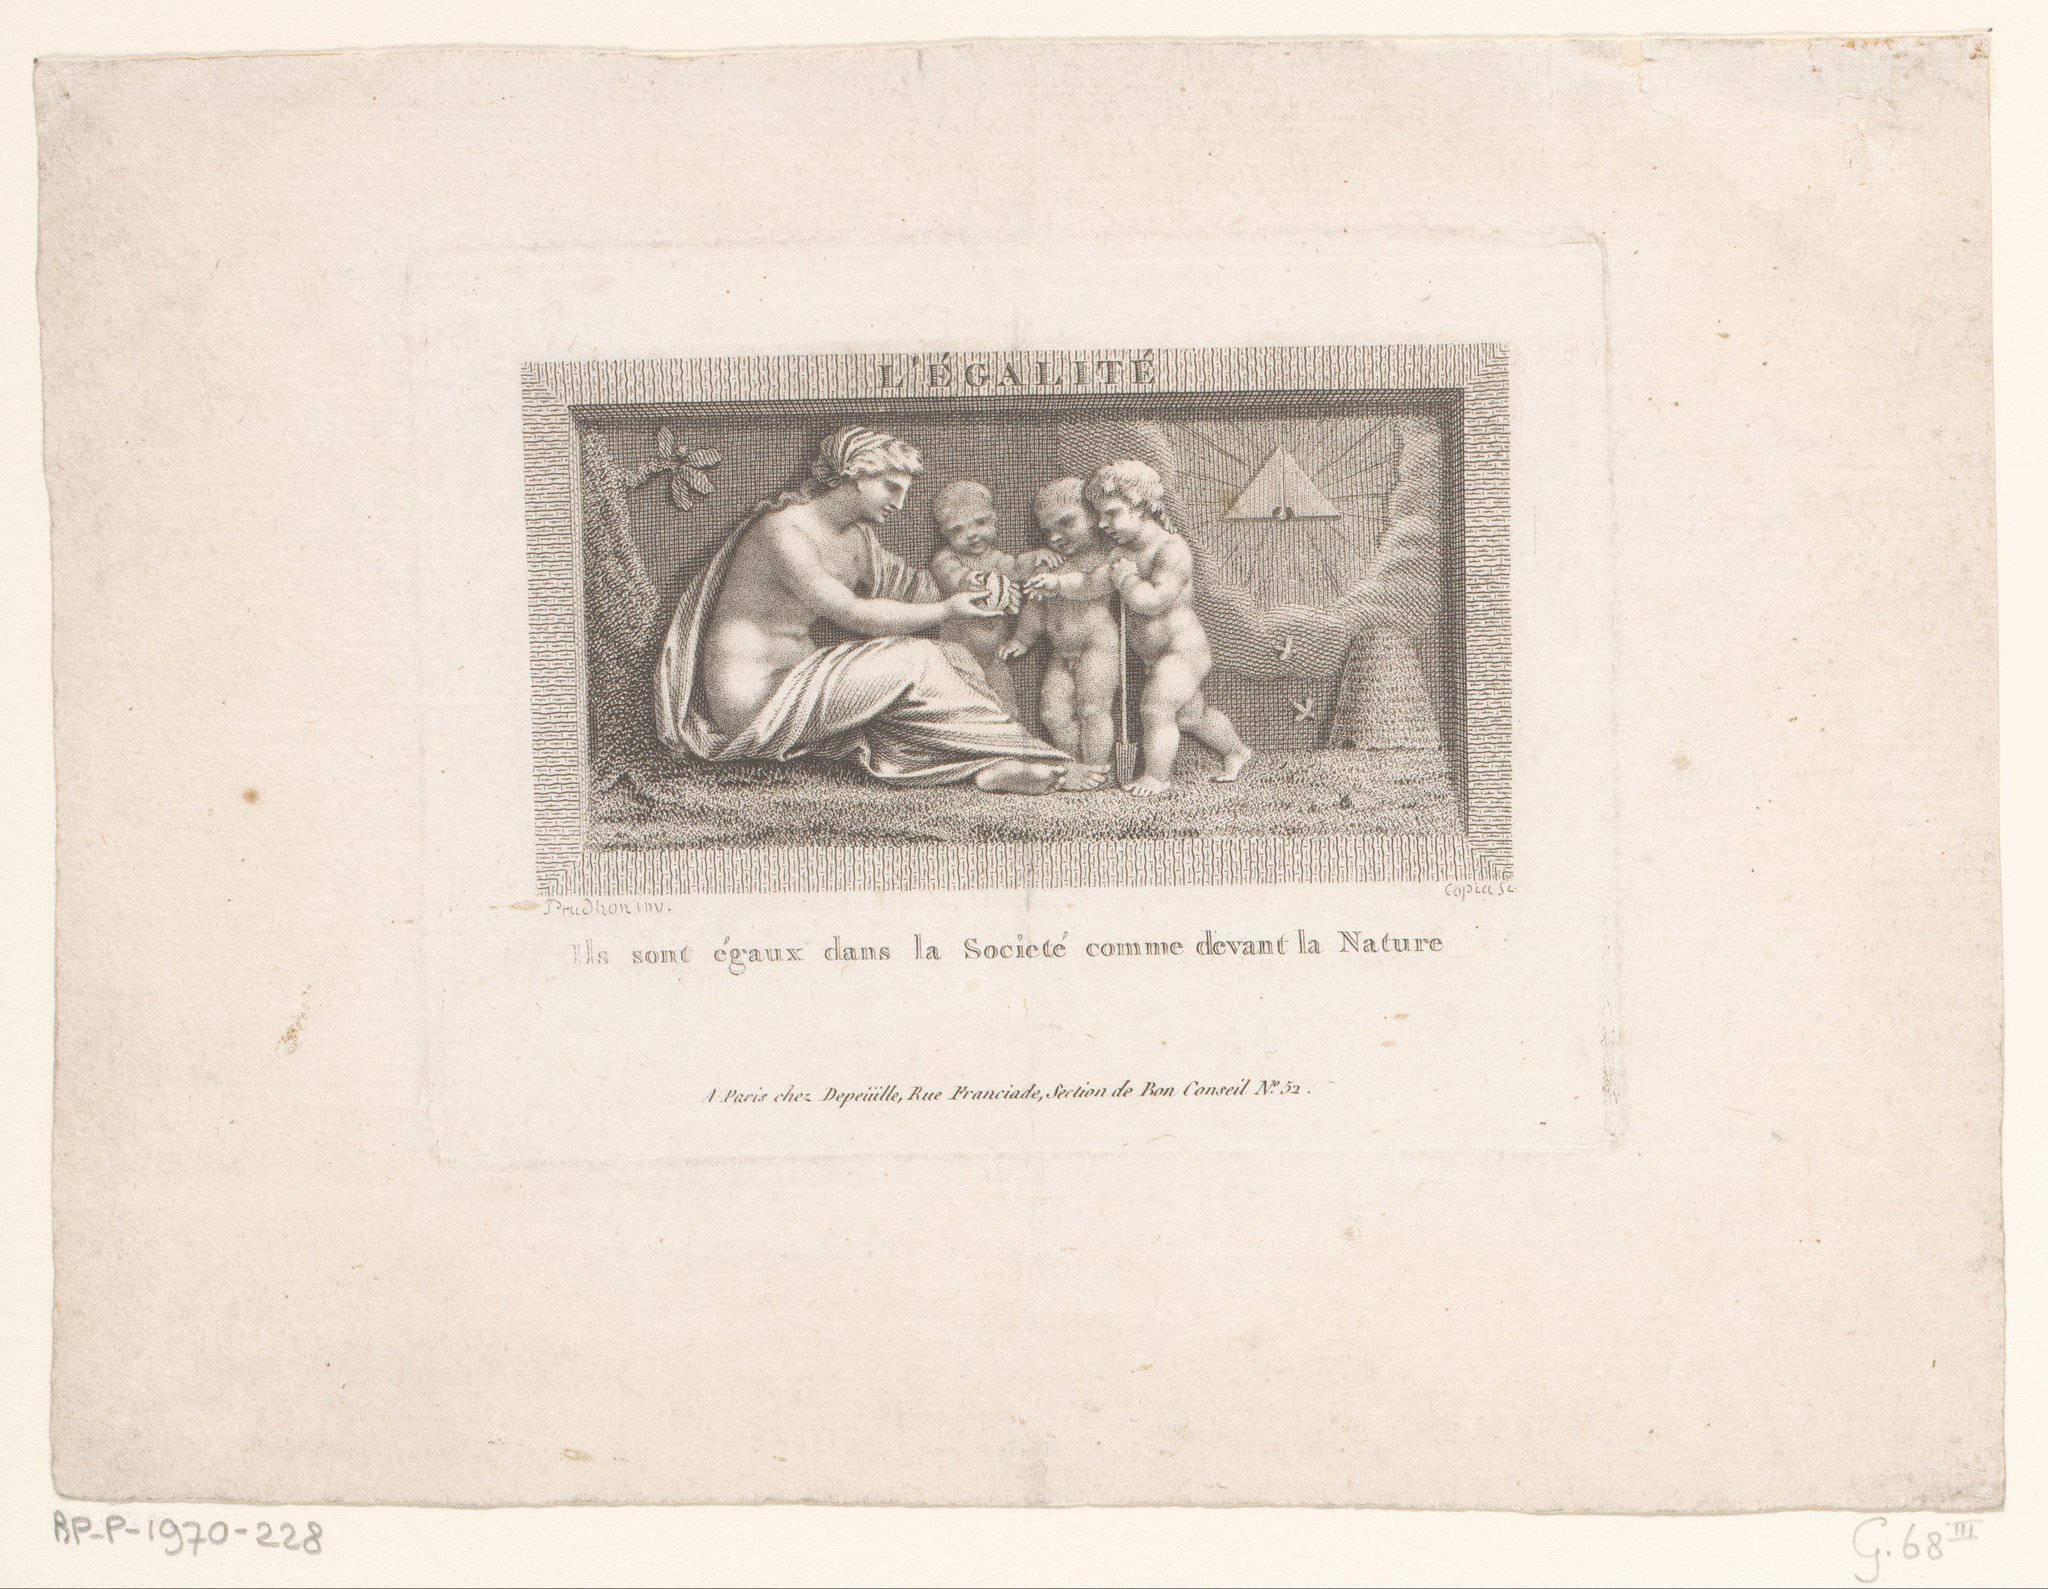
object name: print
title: Gelijkheid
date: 1789-1799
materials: paper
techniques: engraving, etching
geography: paris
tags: 'natura' (allegorical figure or scene; or as diana of ephesus, with many breasts); 'natura' (ripa), equality, equity, fairness, righteousness; 'equalità', 'equità', 'giuditio giusto', 'ordine dritto e giusto', 'ugualità' (ripa)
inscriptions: collector's mark: Lugt 2760, collector's mark: Lugt 2228